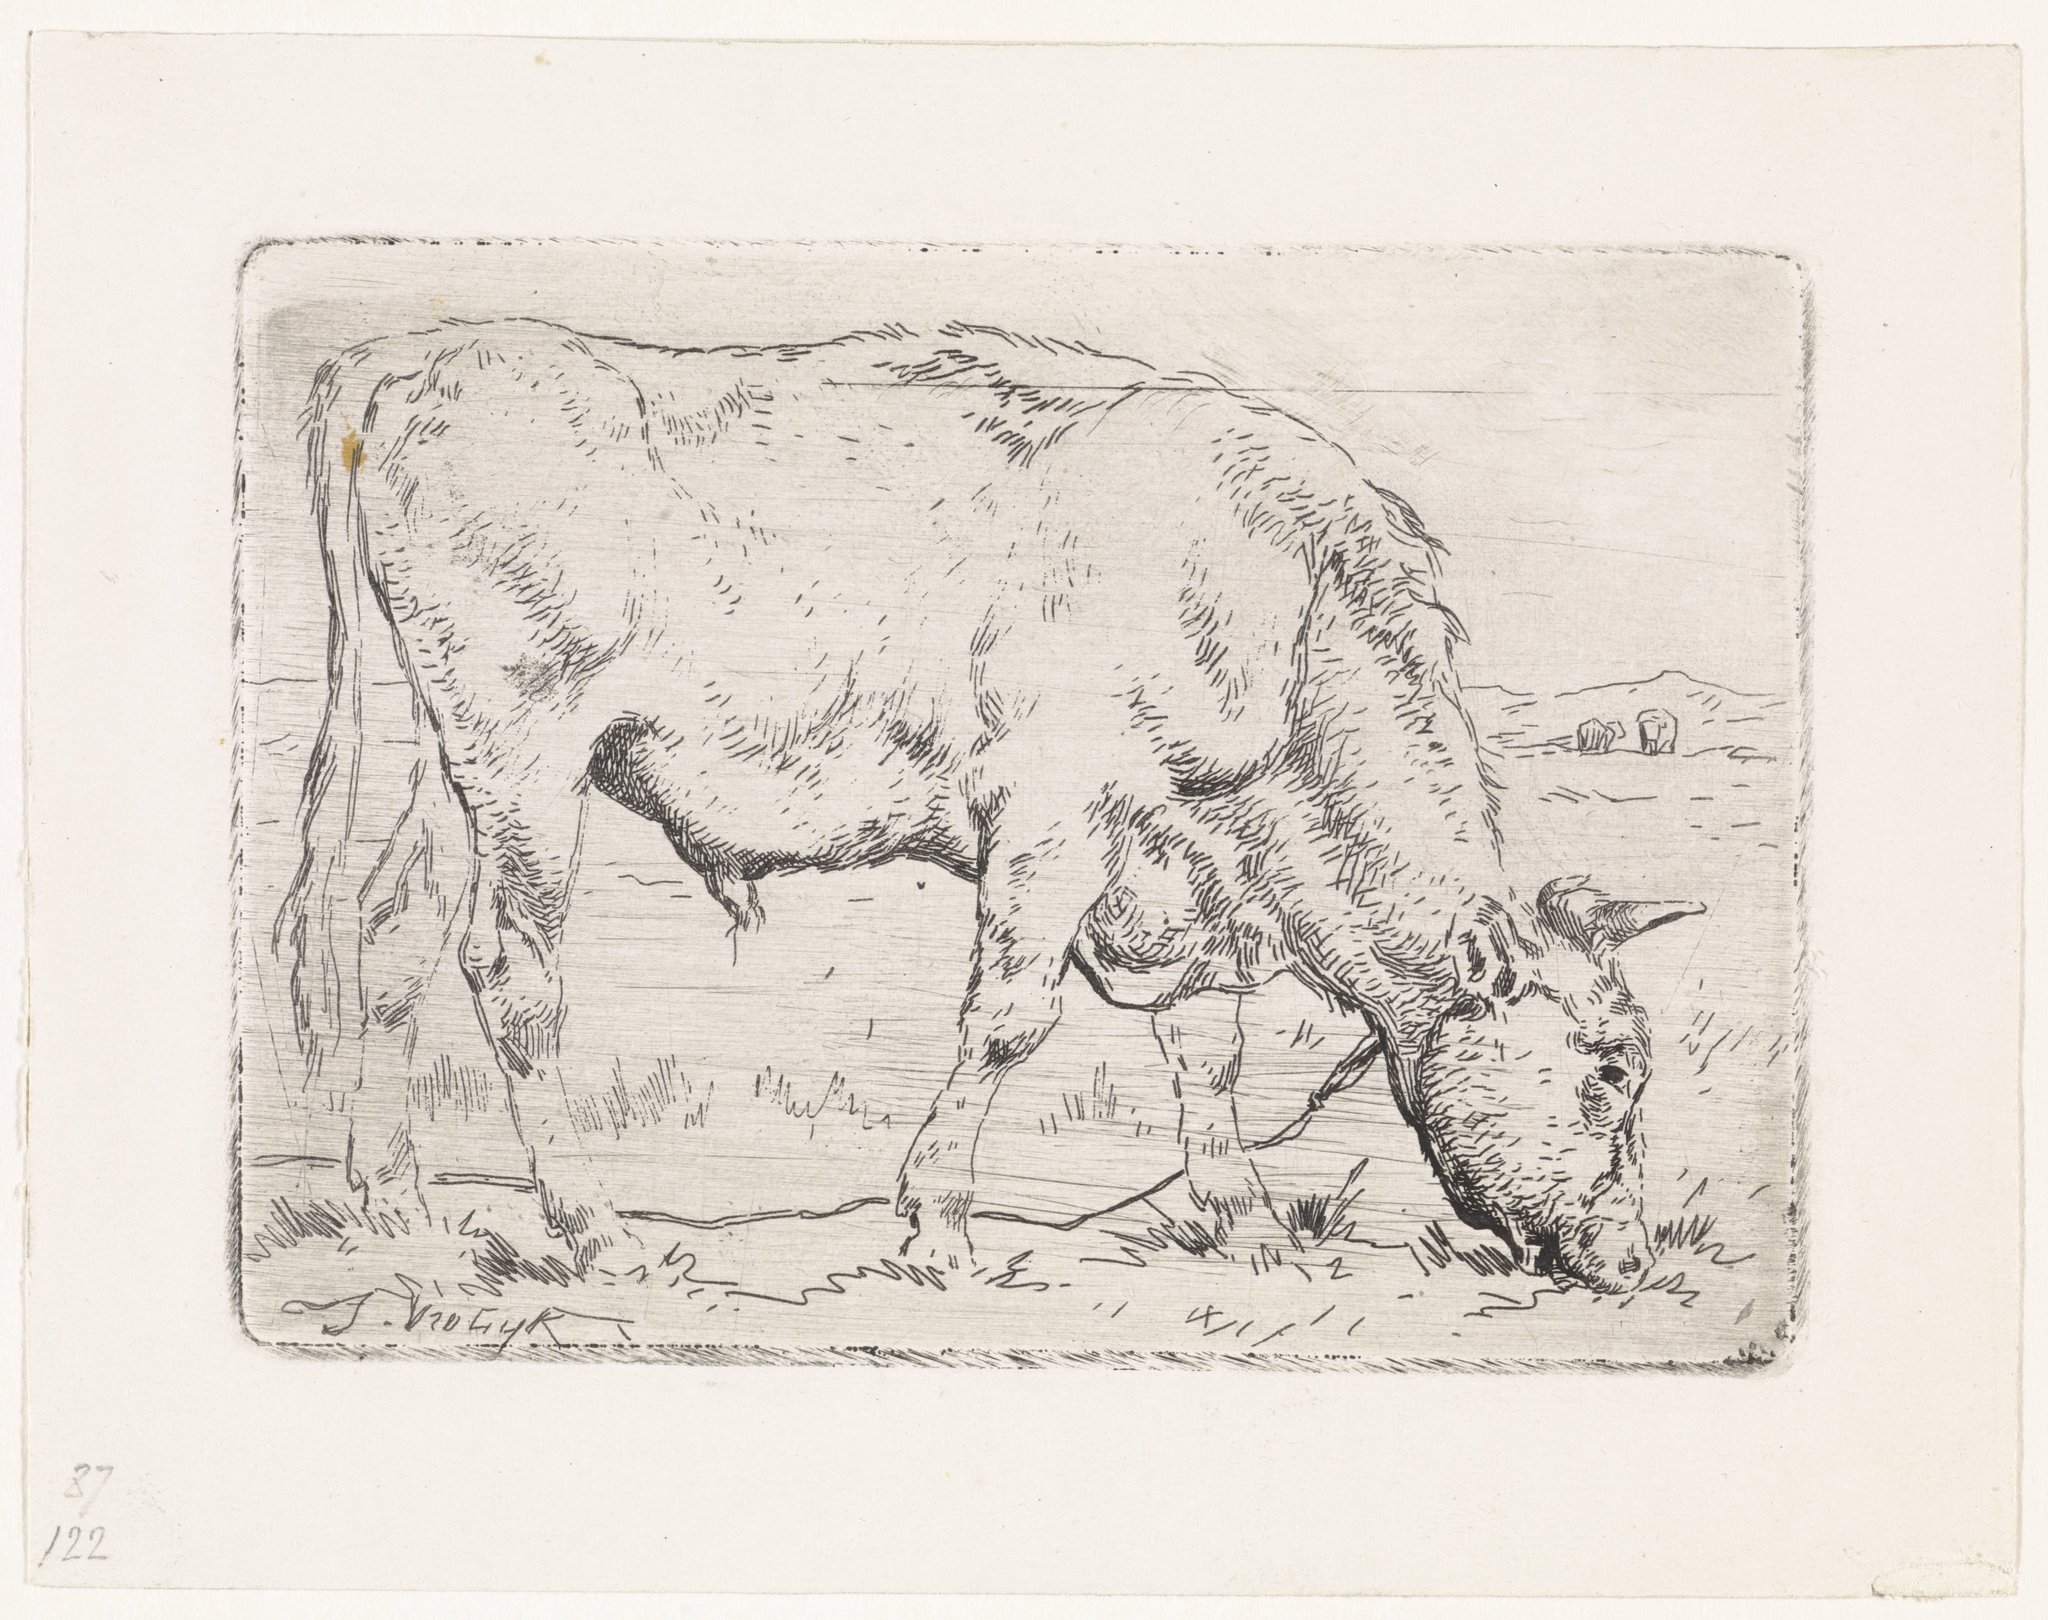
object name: print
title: Landschap met grazende stier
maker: jan vrolijk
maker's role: draughtsman, painter, print maker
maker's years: 1846-1894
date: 1860-1885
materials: paper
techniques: etching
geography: the hague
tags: bull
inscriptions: collector's mark: Lugt 2228